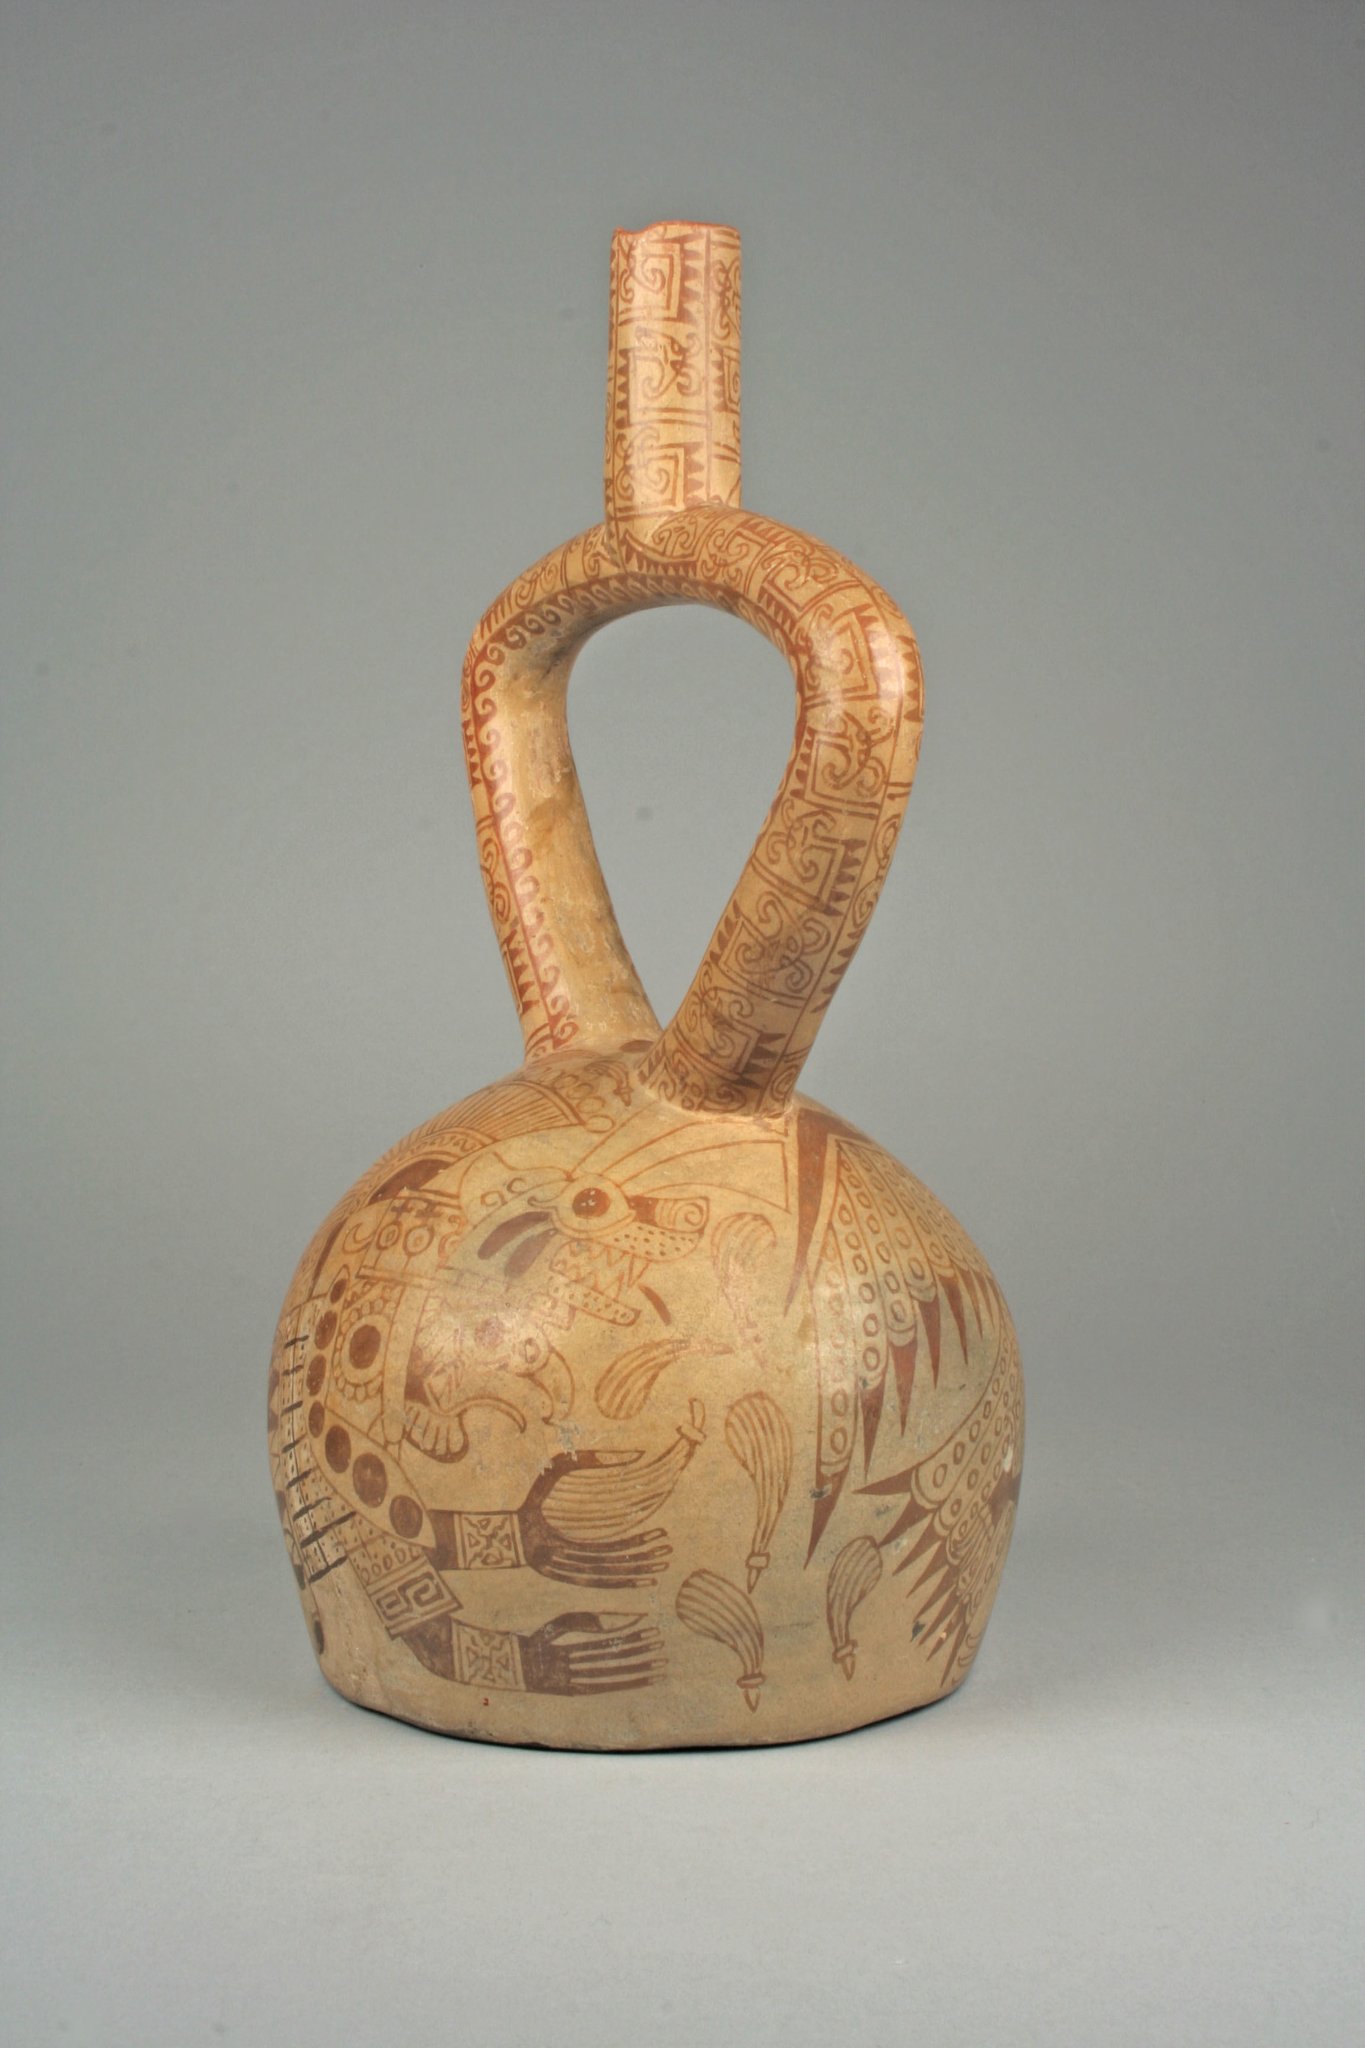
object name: bottle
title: Owl Warrior Bottle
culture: moche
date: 401-700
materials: ceramic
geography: peru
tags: animals